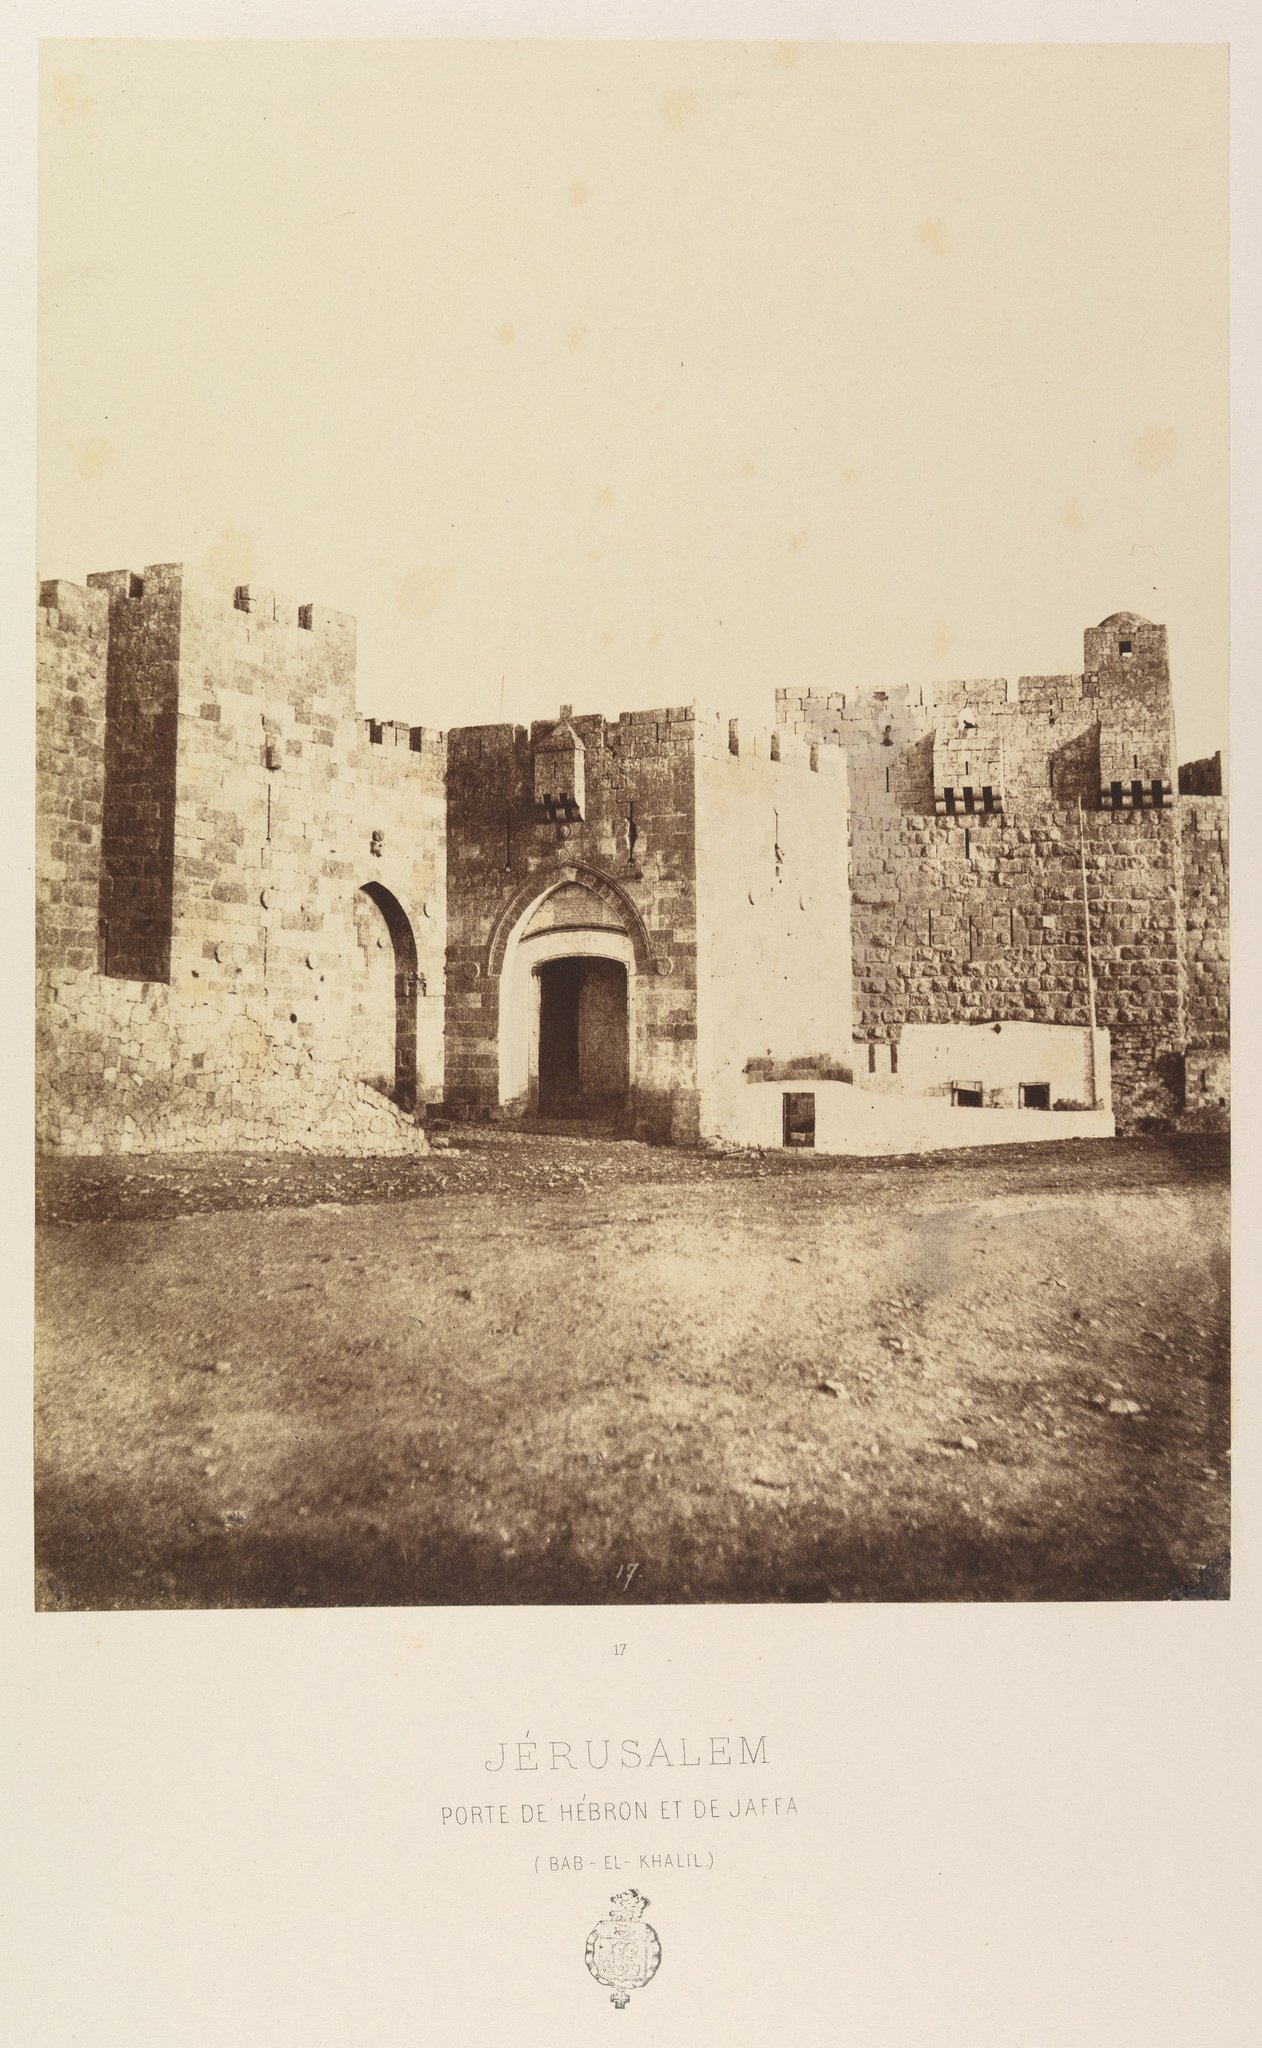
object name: photograph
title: Jérusalem. Porte de Hebron et de Jaffa. (Bab-el-Khalil)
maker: louis de clercq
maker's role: artist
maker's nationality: french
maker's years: 1837-1901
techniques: albumen silver print, paper negative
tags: architecture,arches,gates